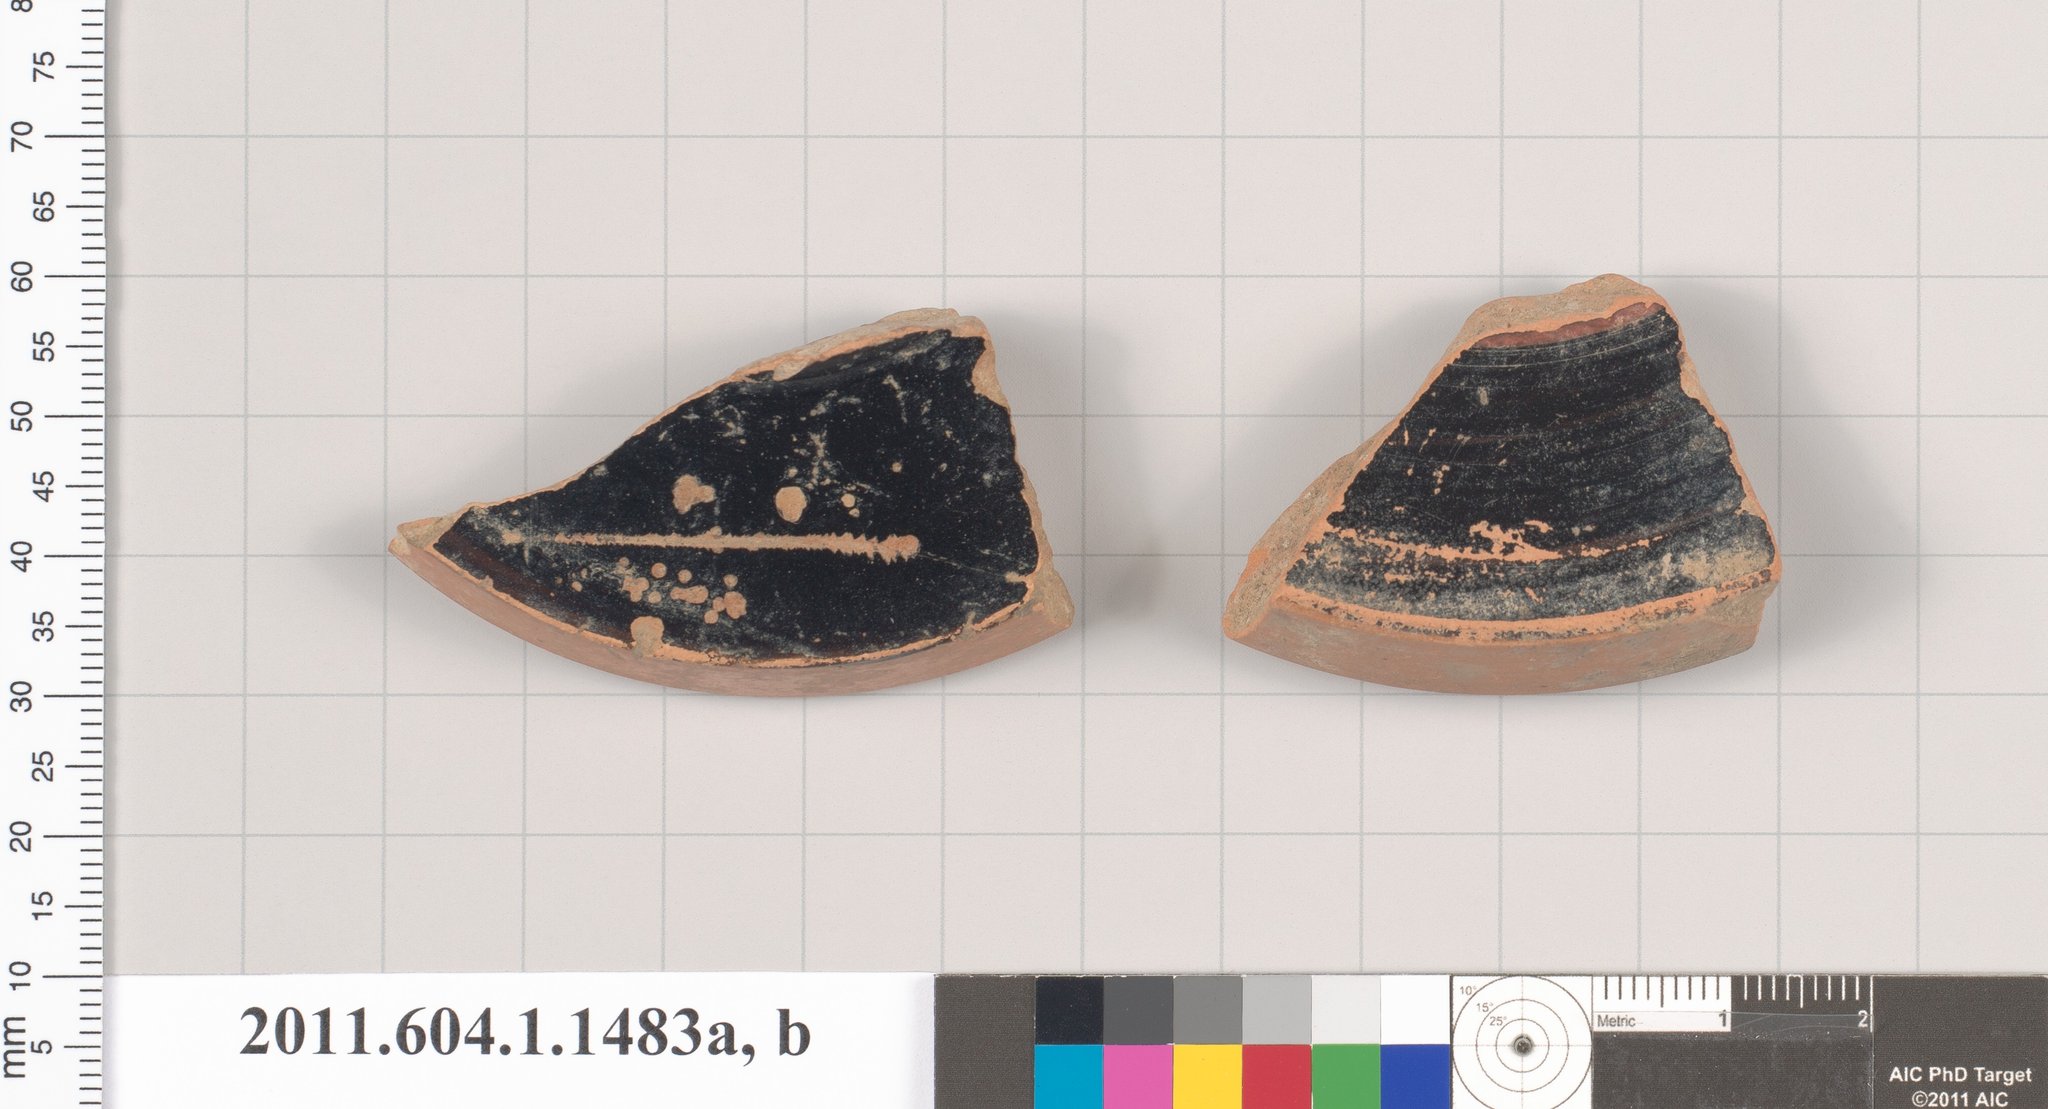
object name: kylix fragment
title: Terracotta fragments of kylikes (drinking cups)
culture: greek, attic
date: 500-401 BCE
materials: terracotta